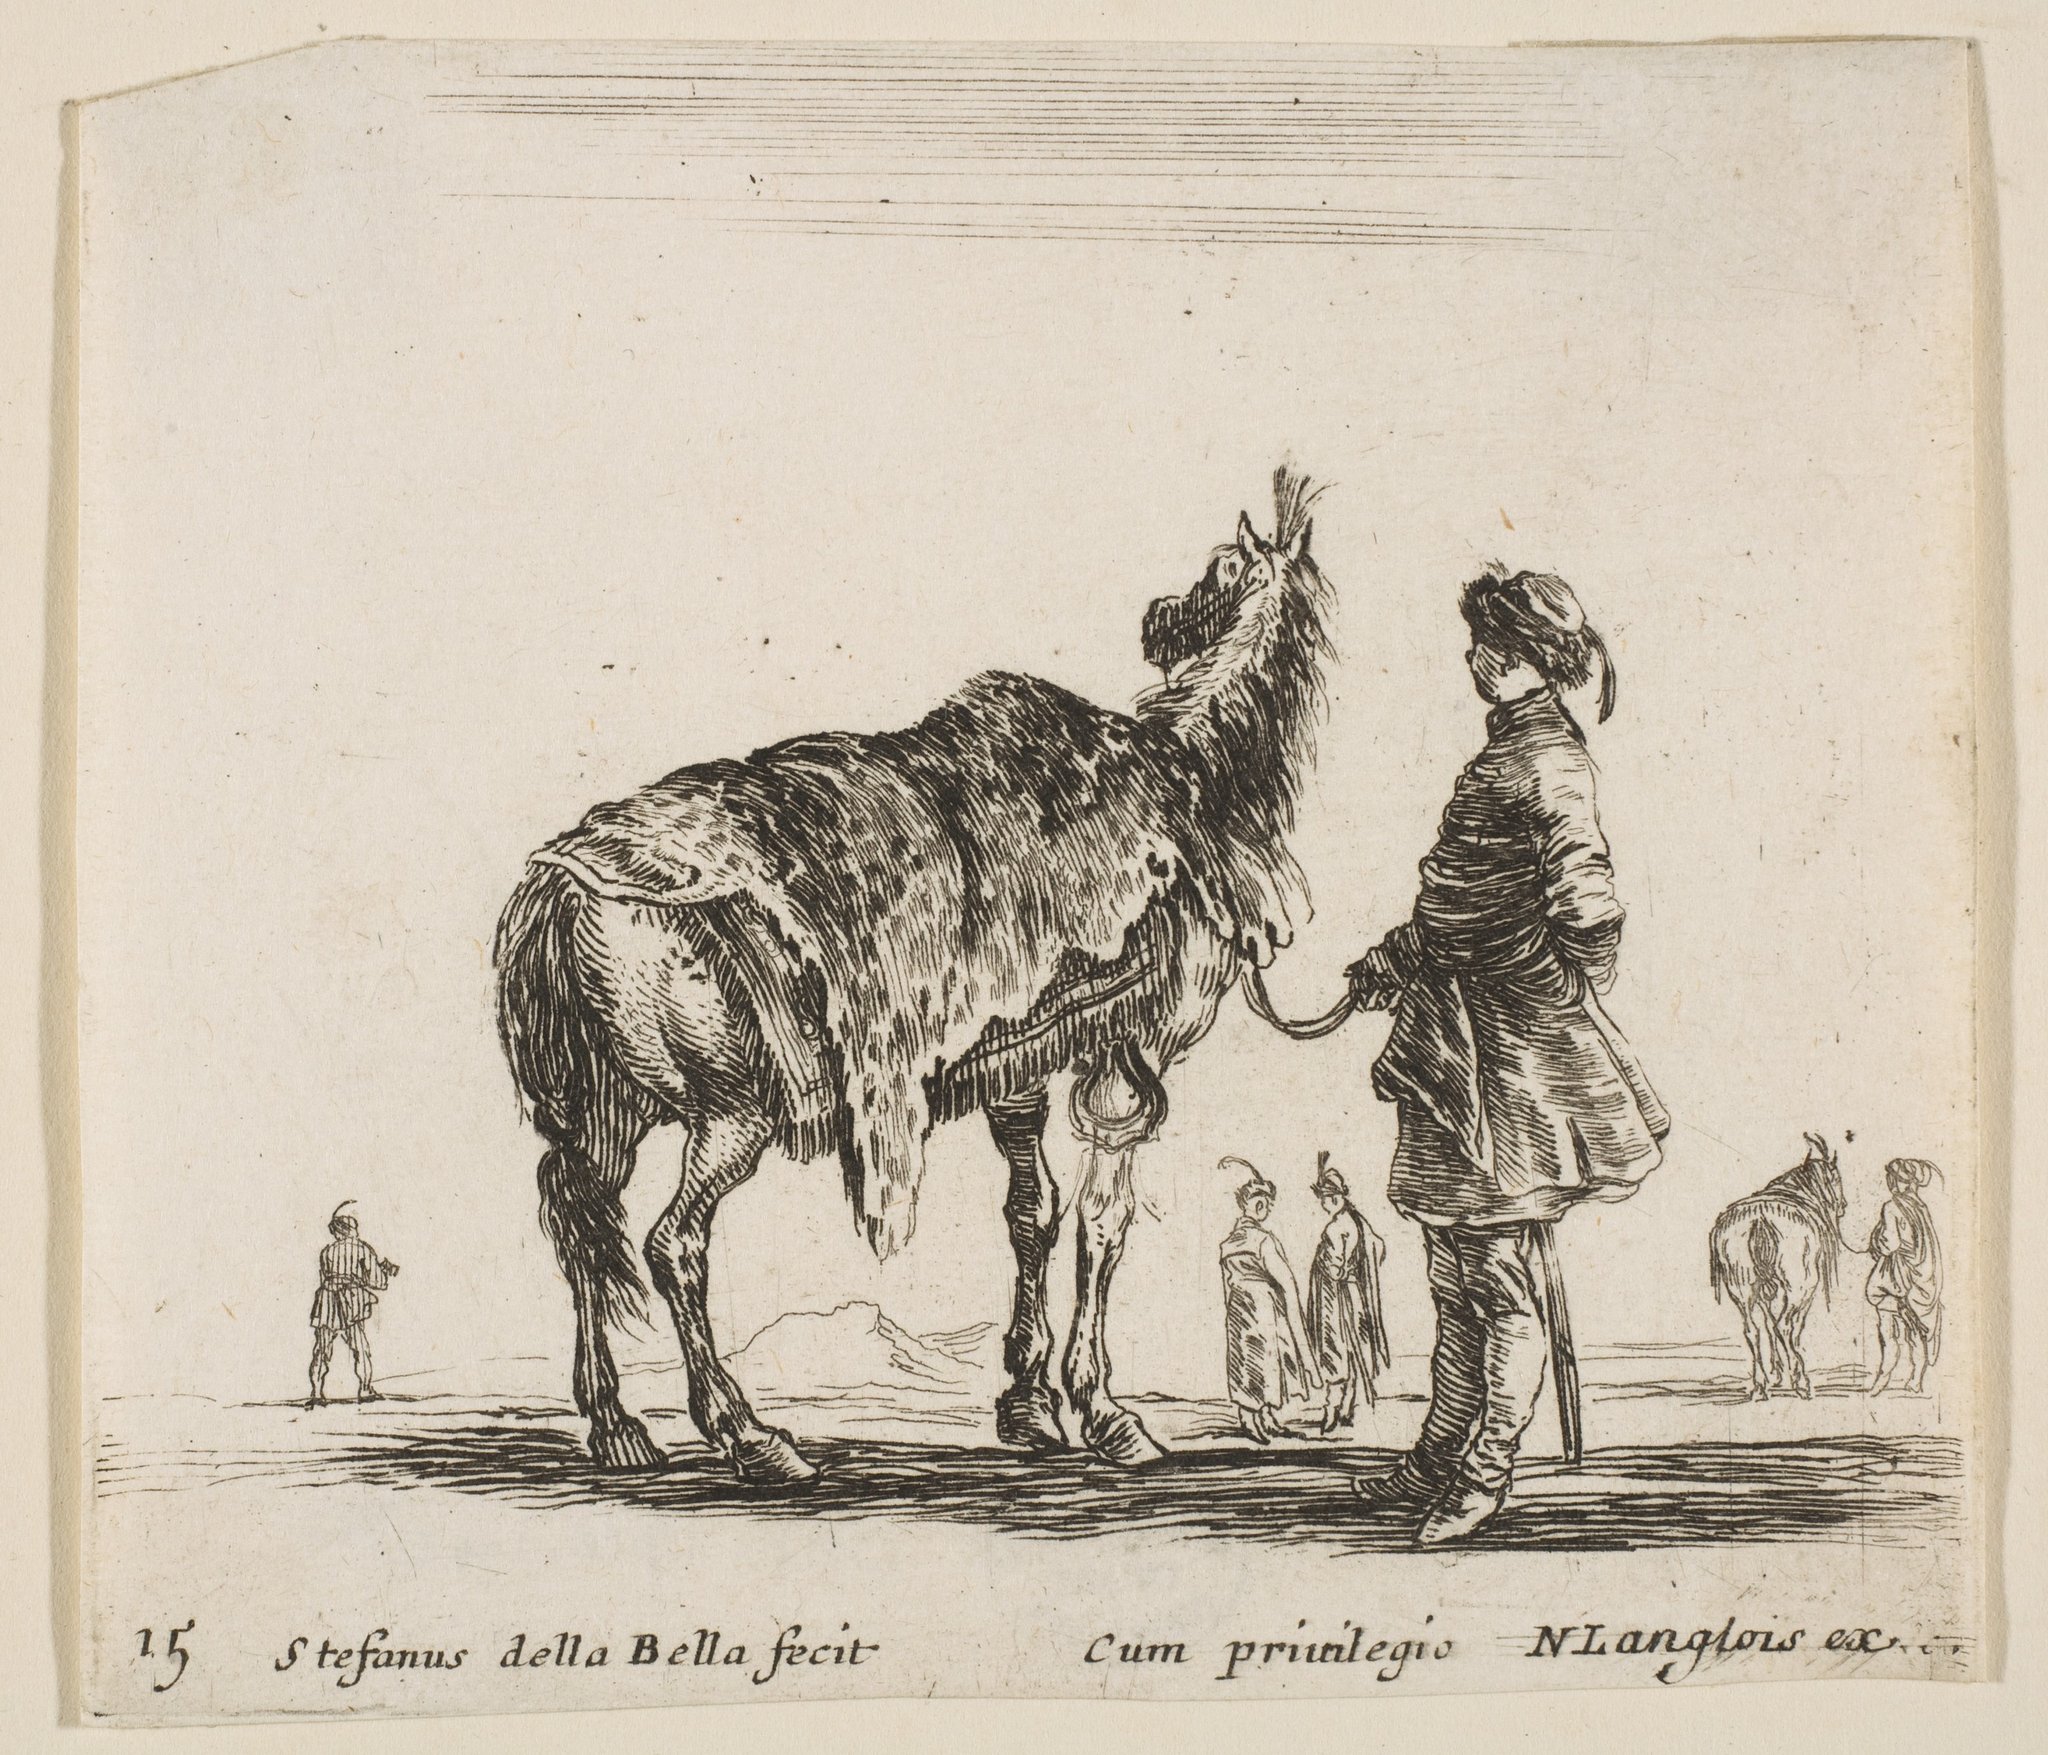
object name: print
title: A Polish nobleman, facing away, holding his horse covered in leopard skin, four men and a horse in background, plate 15 from "Diversi capricci"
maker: stefano della bella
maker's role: artist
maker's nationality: italian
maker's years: 1610-1664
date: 1644-1647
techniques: etching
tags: men,horses